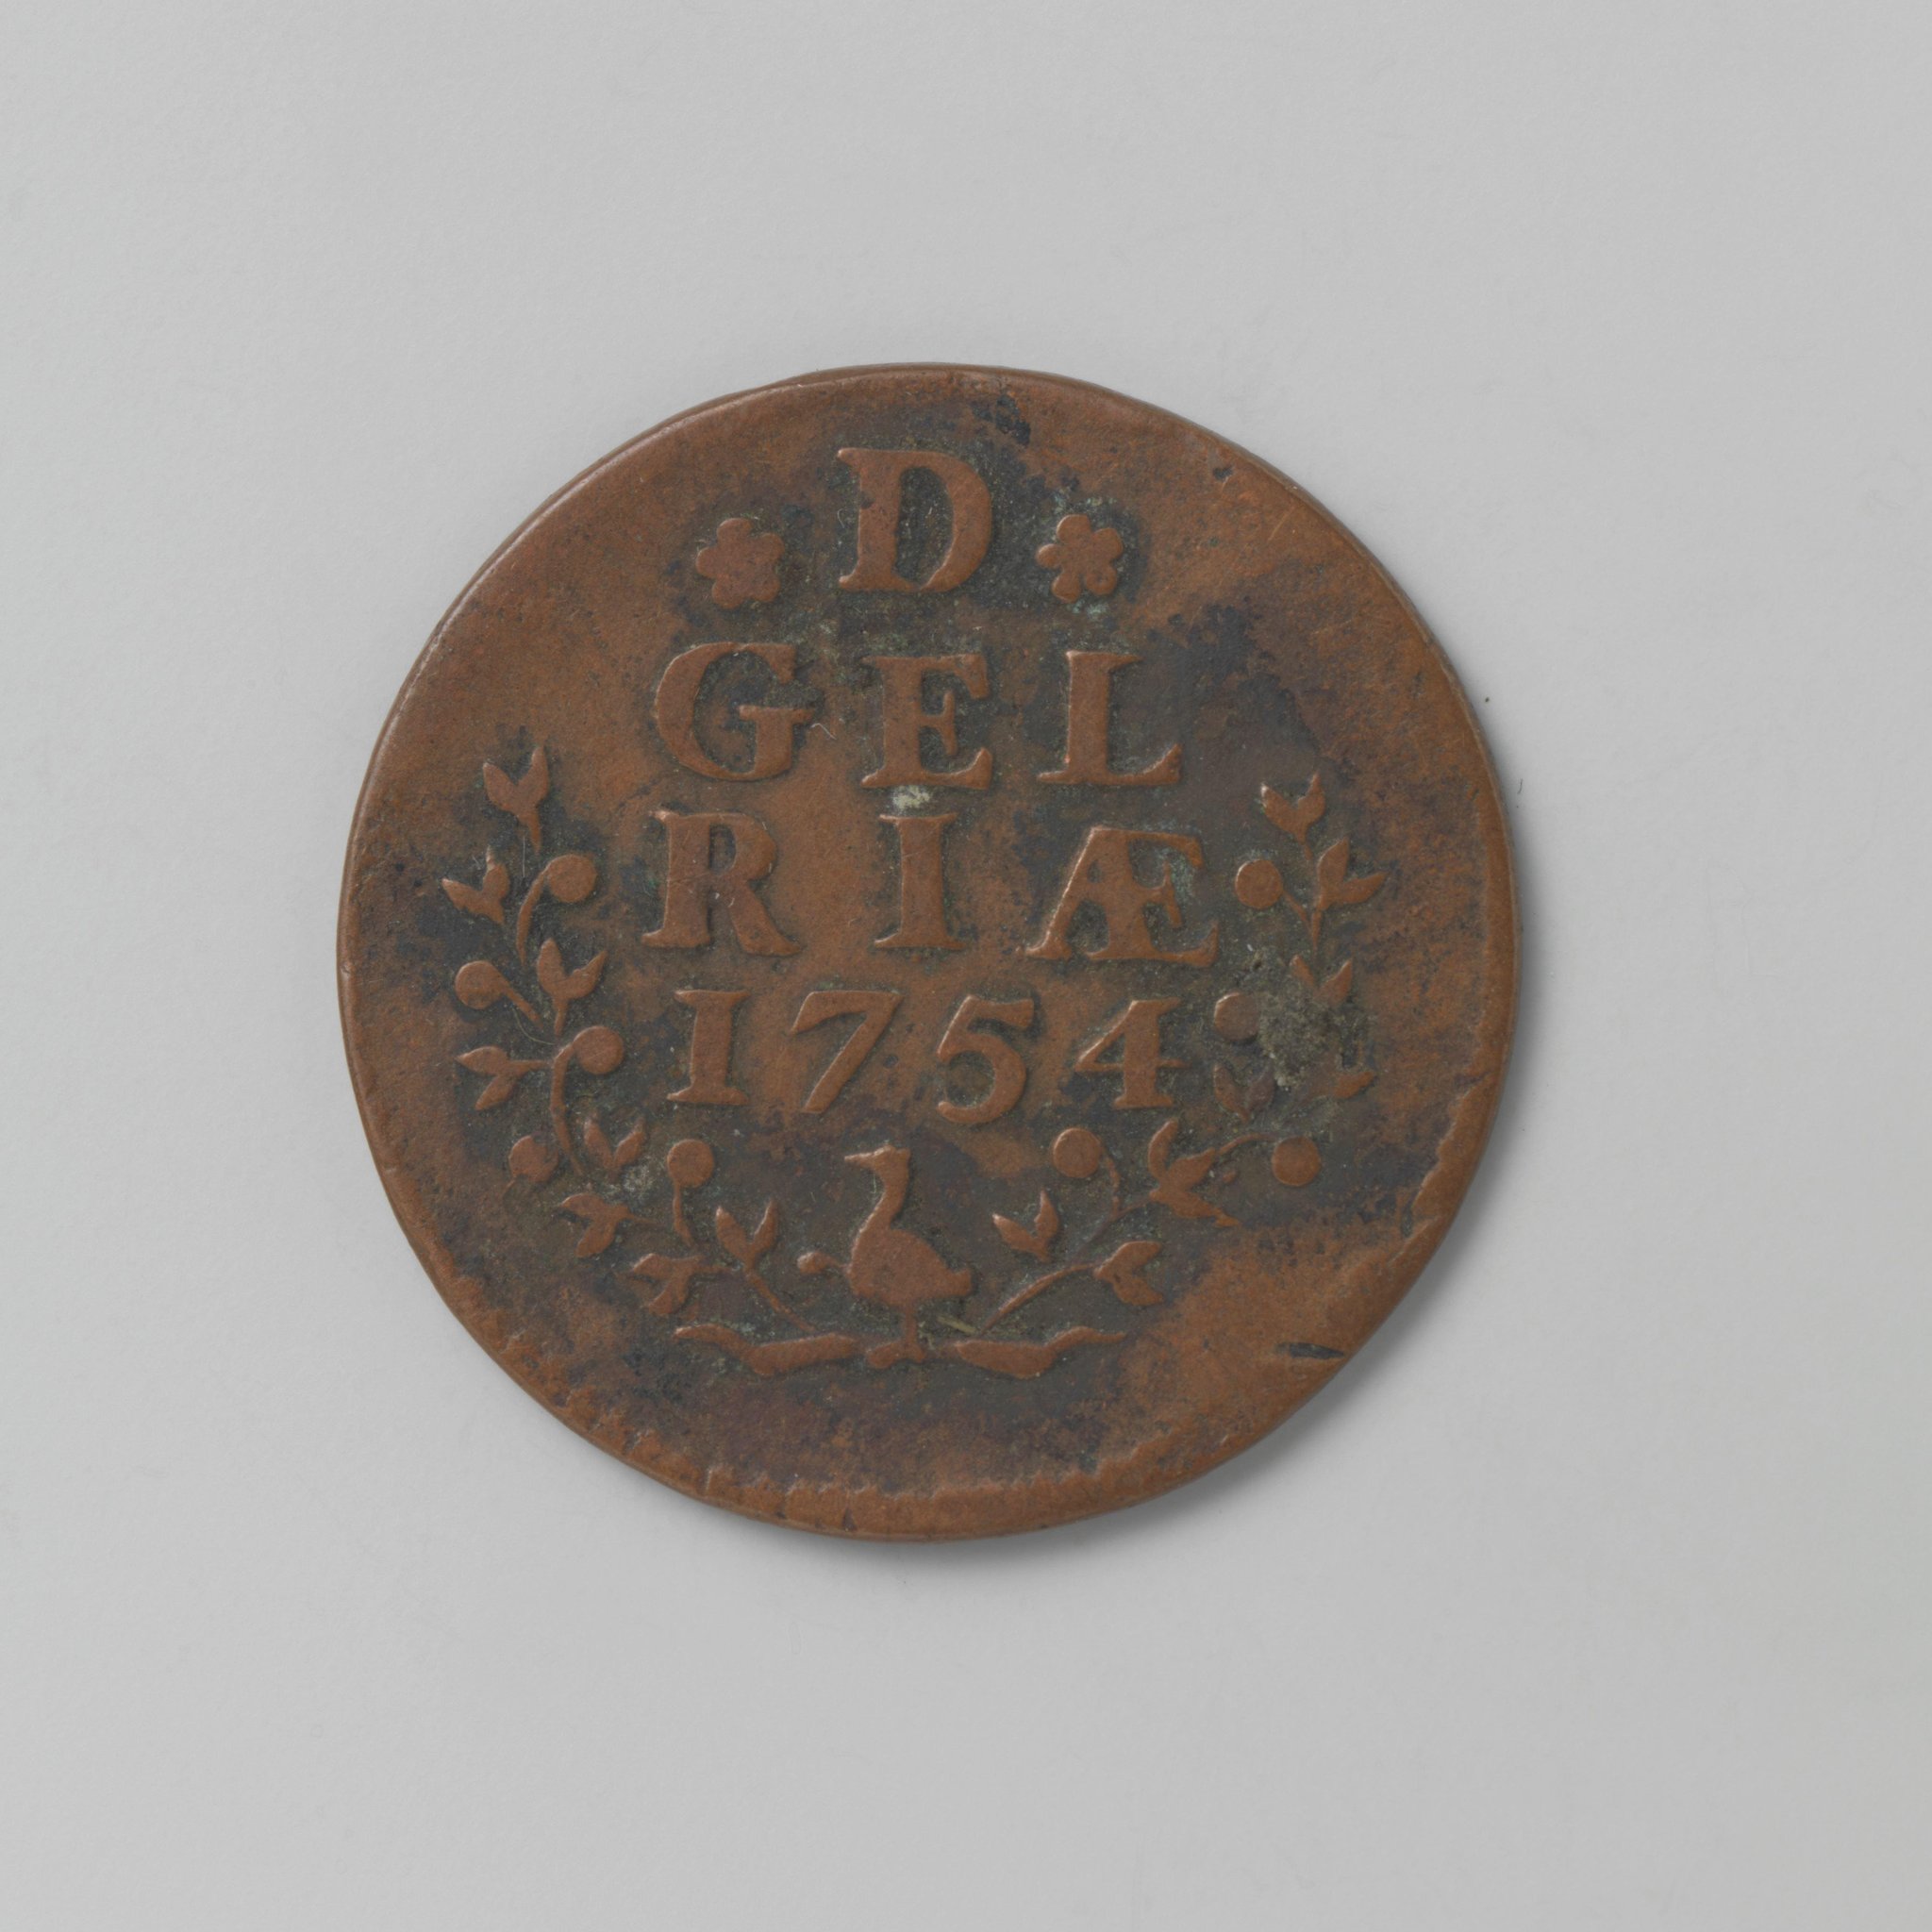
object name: coin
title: Gelderland, duit, 1754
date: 1754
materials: copper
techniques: striking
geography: harderwijk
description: Koperen munt. Voorzijde: binnen versiering in drie regels D/GEL/RIAE, daaronder jaartal en muntmeesterteken. Keerzijde: gekroond Gelders wapenschild.